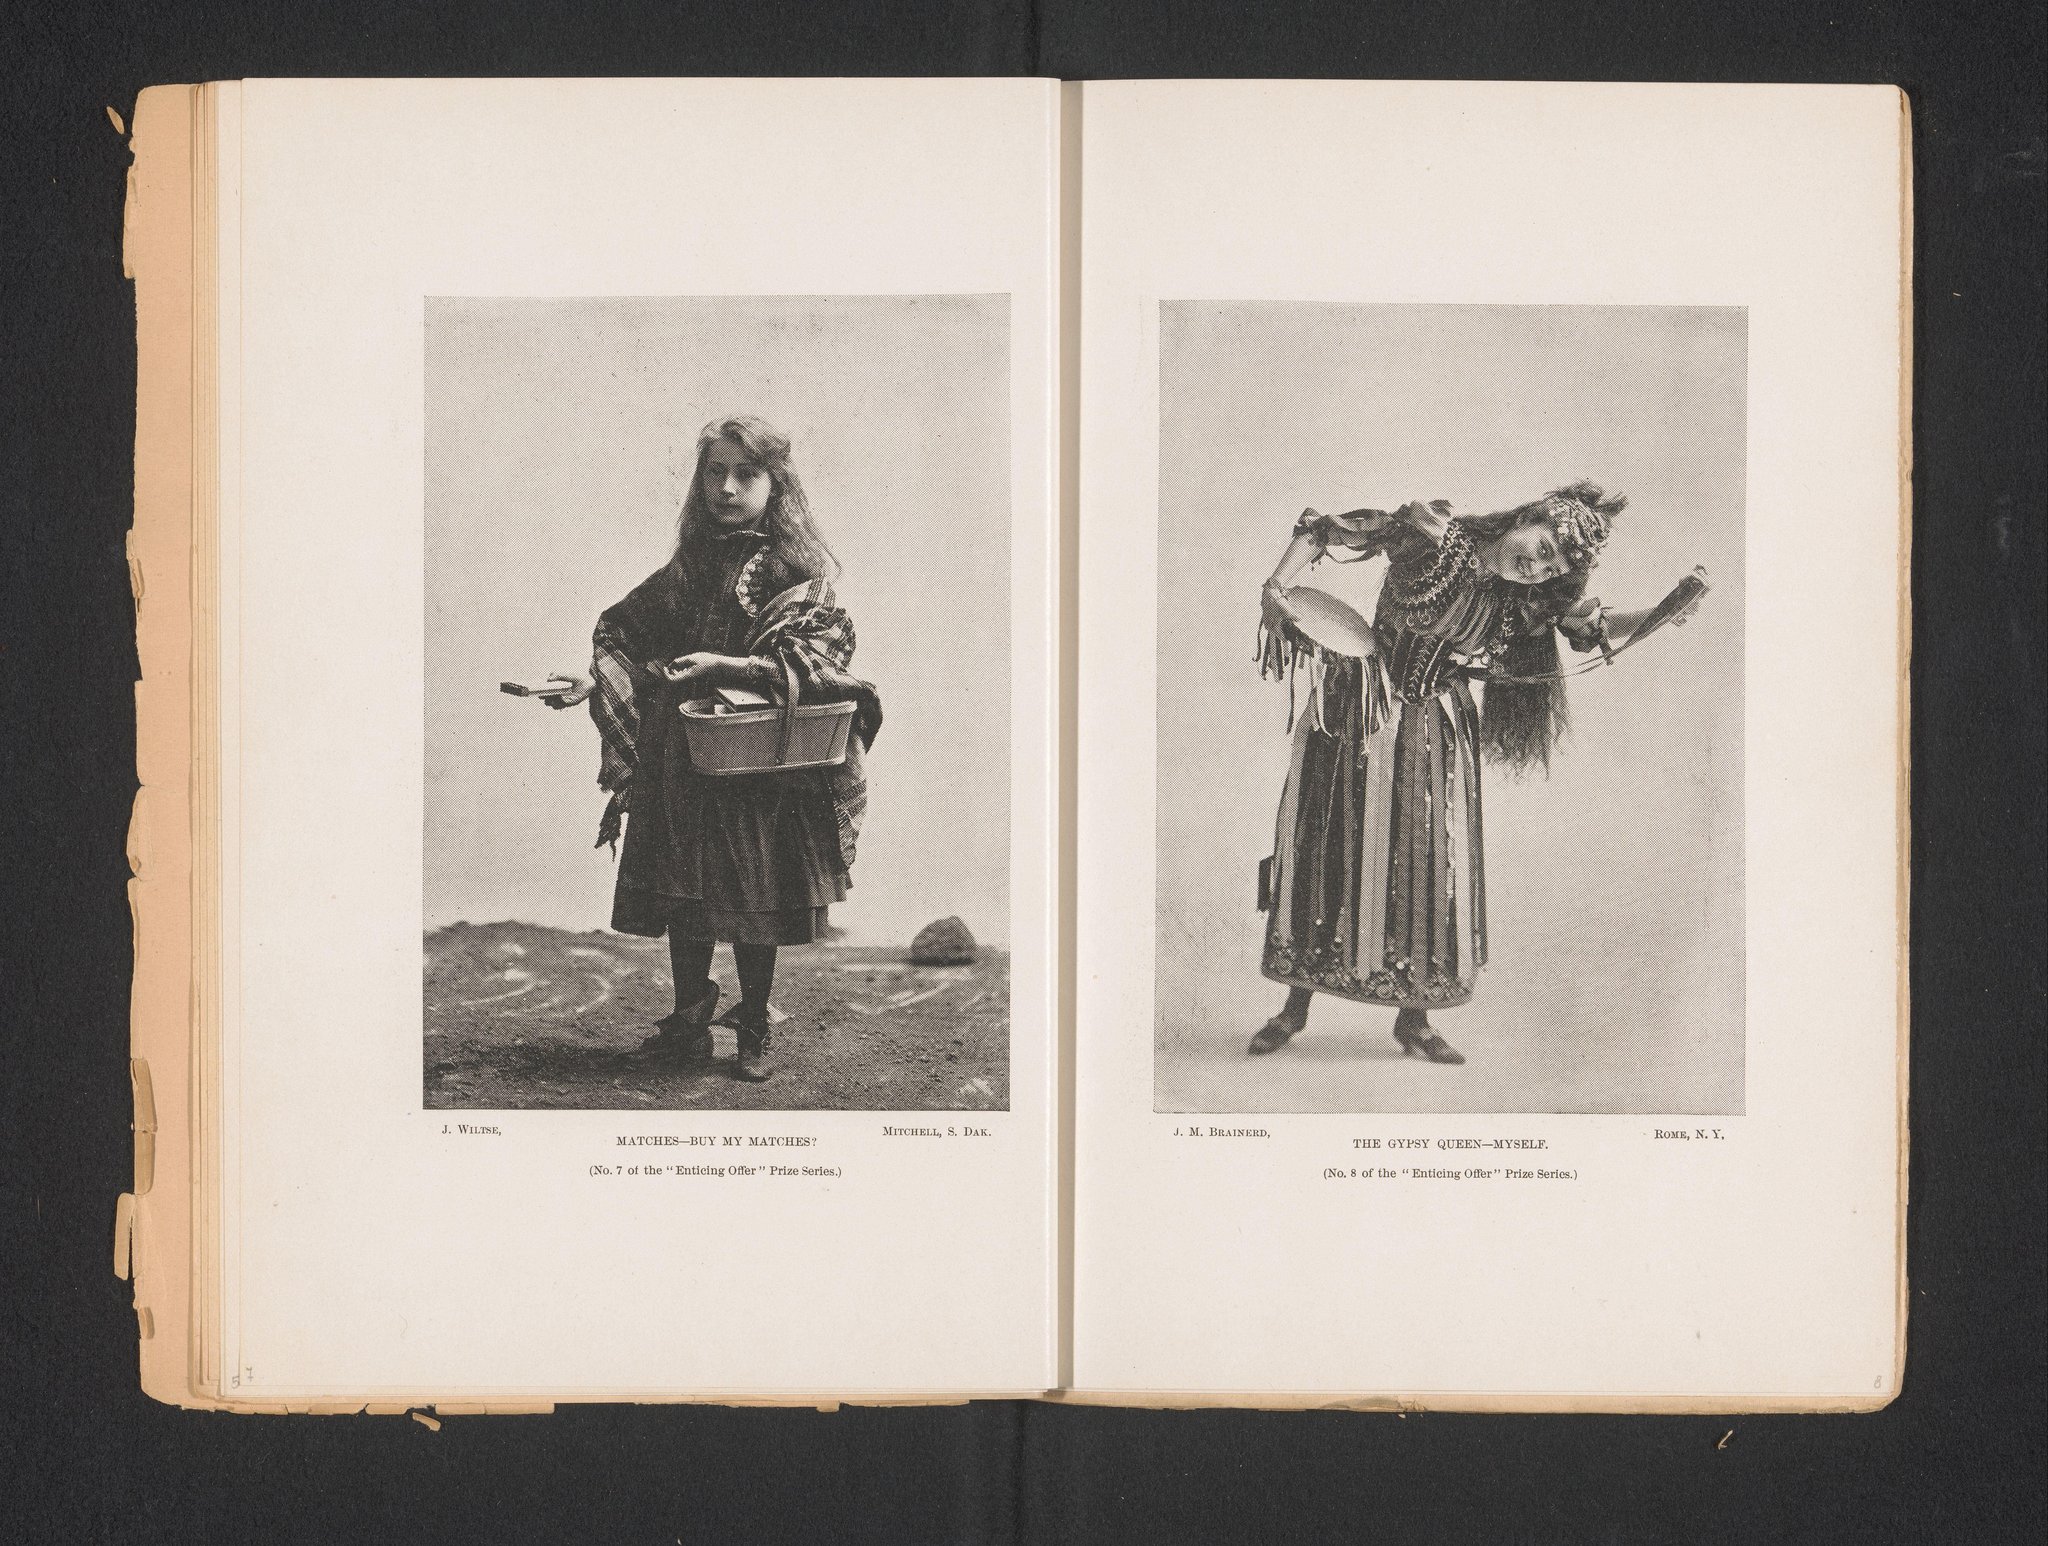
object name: photomechanical print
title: The Gypsy Queen - Myself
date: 1887-1892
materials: paper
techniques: autotype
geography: new york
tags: historical persons not known by name - bb - woman, tambourine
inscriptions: inscription: ‘(No. 8 of the "Enticing Offer" Prize Series.)’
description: Prent acht van vijftien prenten tussen pagina viii en pagina 545.